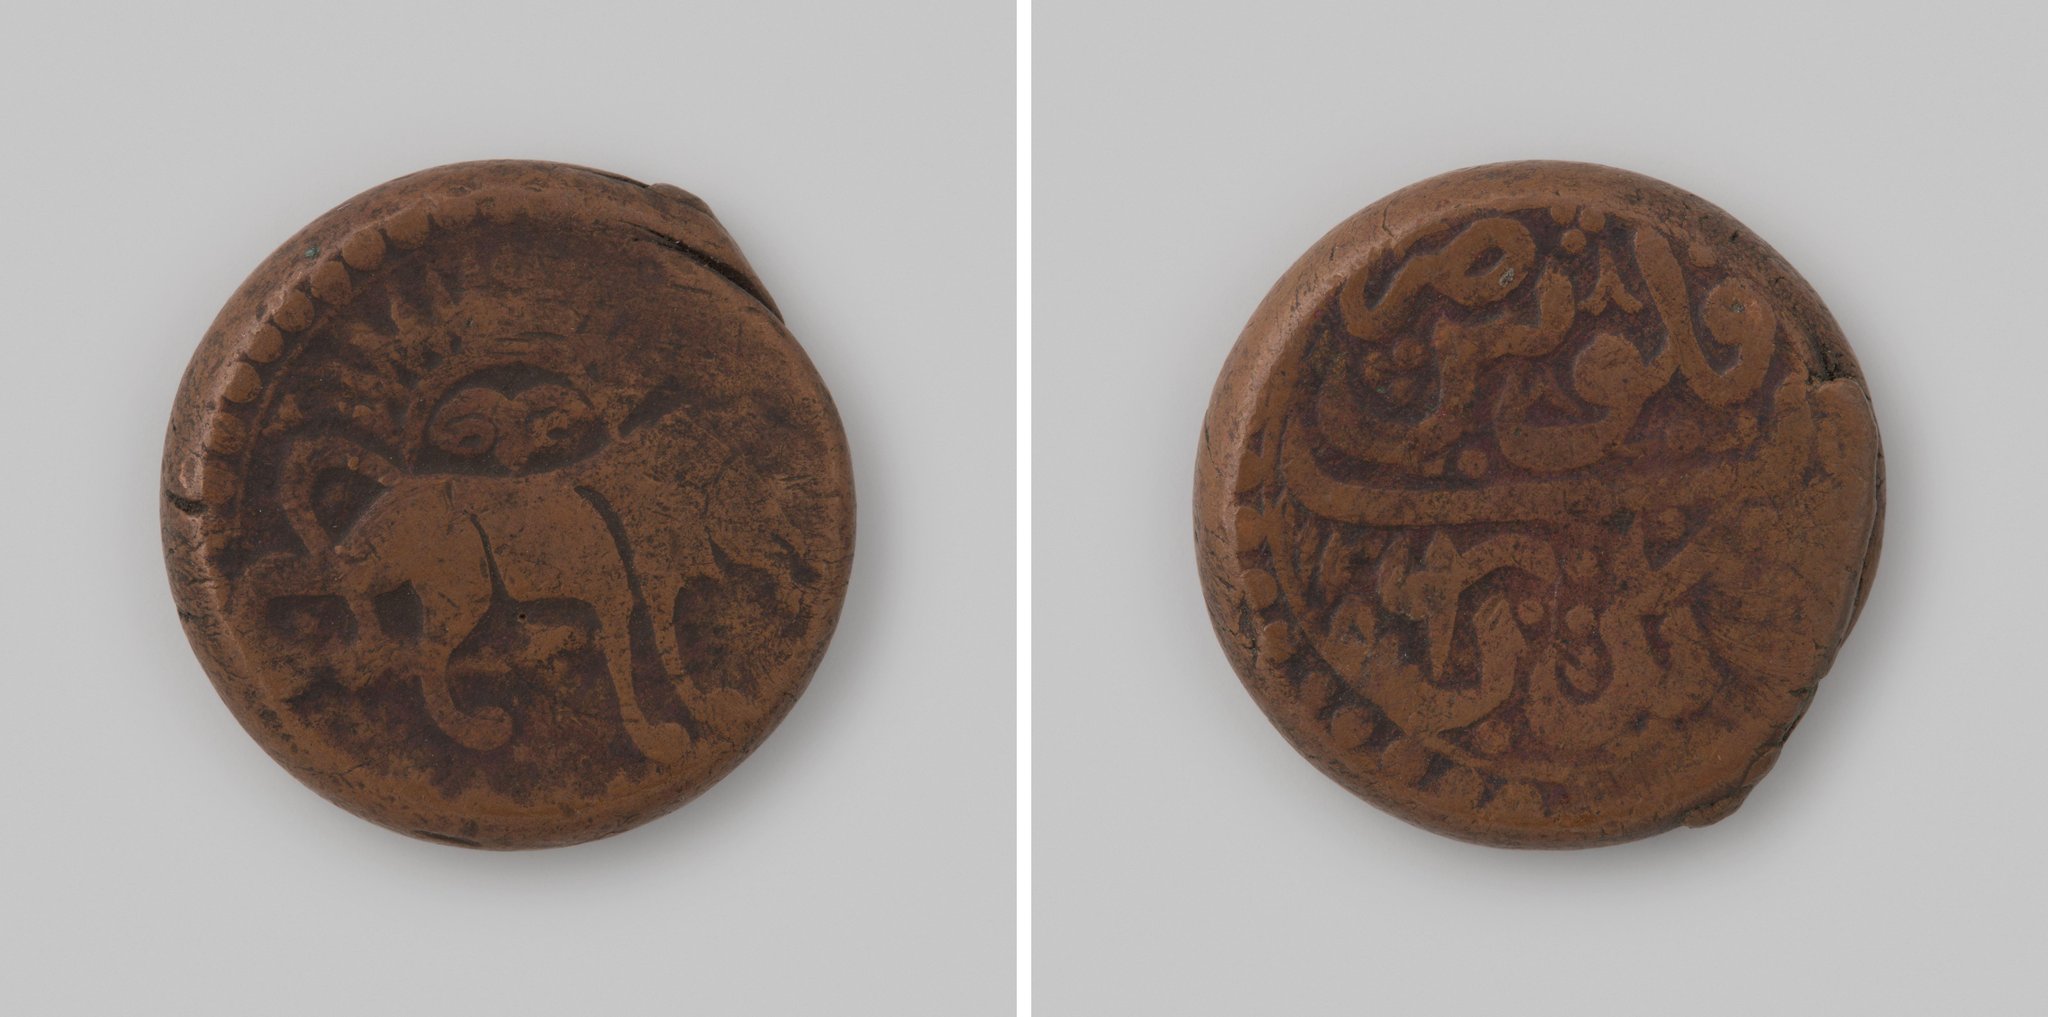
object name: coin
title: Perzië, ten tijde van sjah Tahmasp II, dubbele falus, 1138 [=1725], Mazandaran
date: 1725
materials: copper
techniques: striking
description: Koperen munt. Voorzijde: leeuw naar rechts, waarboven stalende opkoende zon, waarin gezicht. Keerzijde: in Arabische lettertekens in vier regels muntplaats-aanduiding en op derde regel links jaartal-aanduiding. Geslagen te Mazandaran.